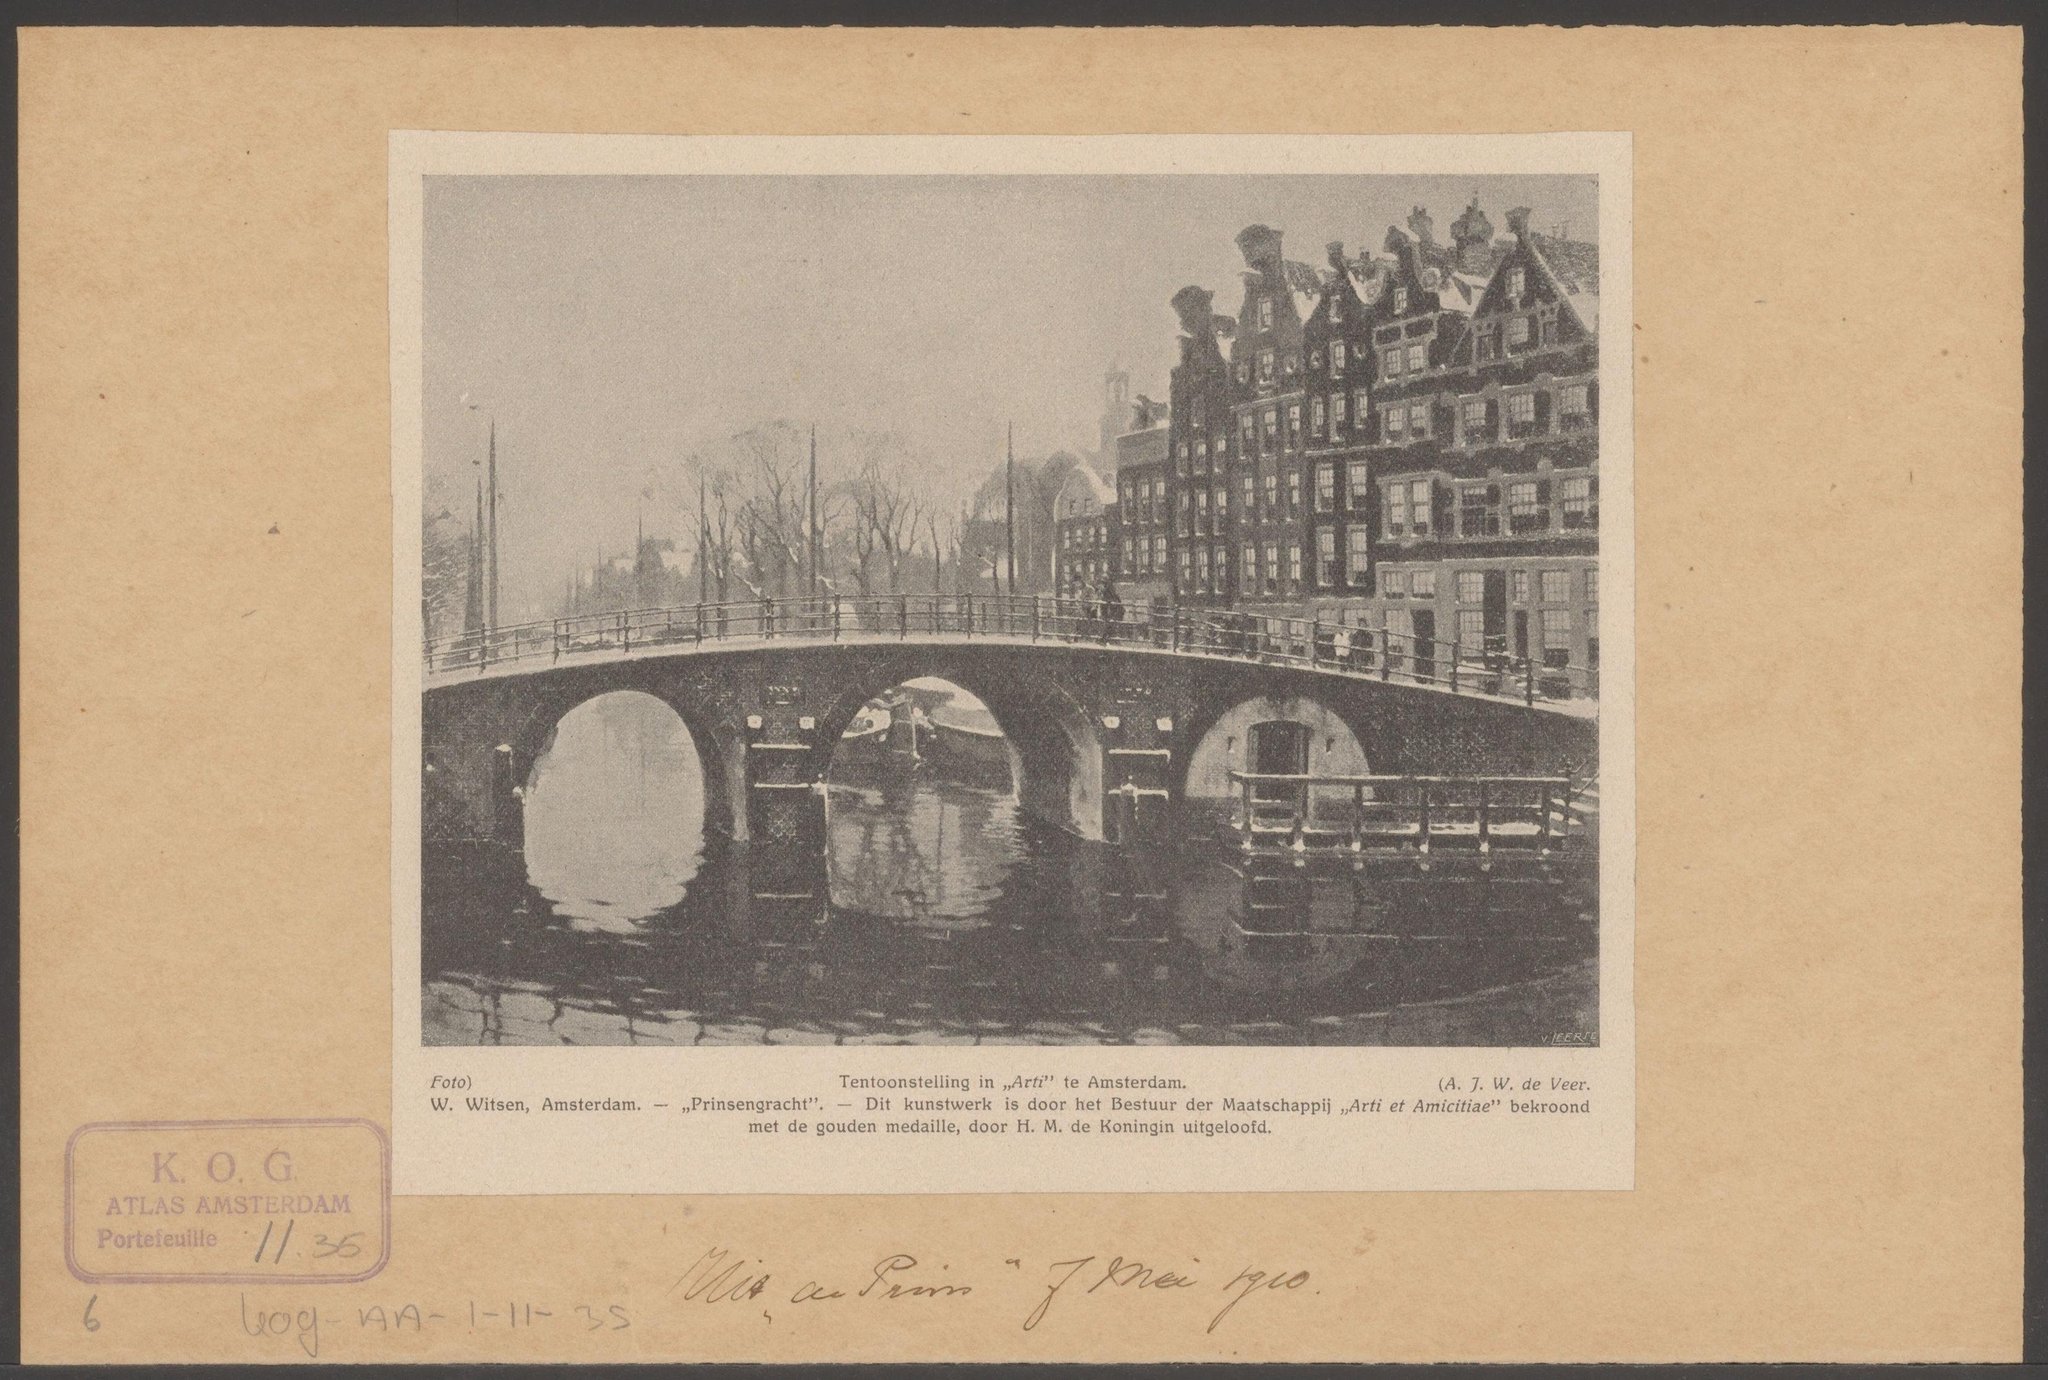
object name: photomechanical print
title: Gezicht op de Prinsengracht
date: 1910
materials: paper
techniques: letterpress printing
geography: amsterdam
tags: city-view in general; 'veduta', canal, the usual house or row of houses, bridge in city across river, canal, etc.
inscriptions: collector's mark: ‘11.35’ Lugt 1641b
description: Onderwerpsrubriek binnen de Atlas Amsterdam: Prinsengracht, Korte Prinsengracht, Prins Hendrikkade. Zie ook Portefeuille 1: gezichten van het IJ op de stad.